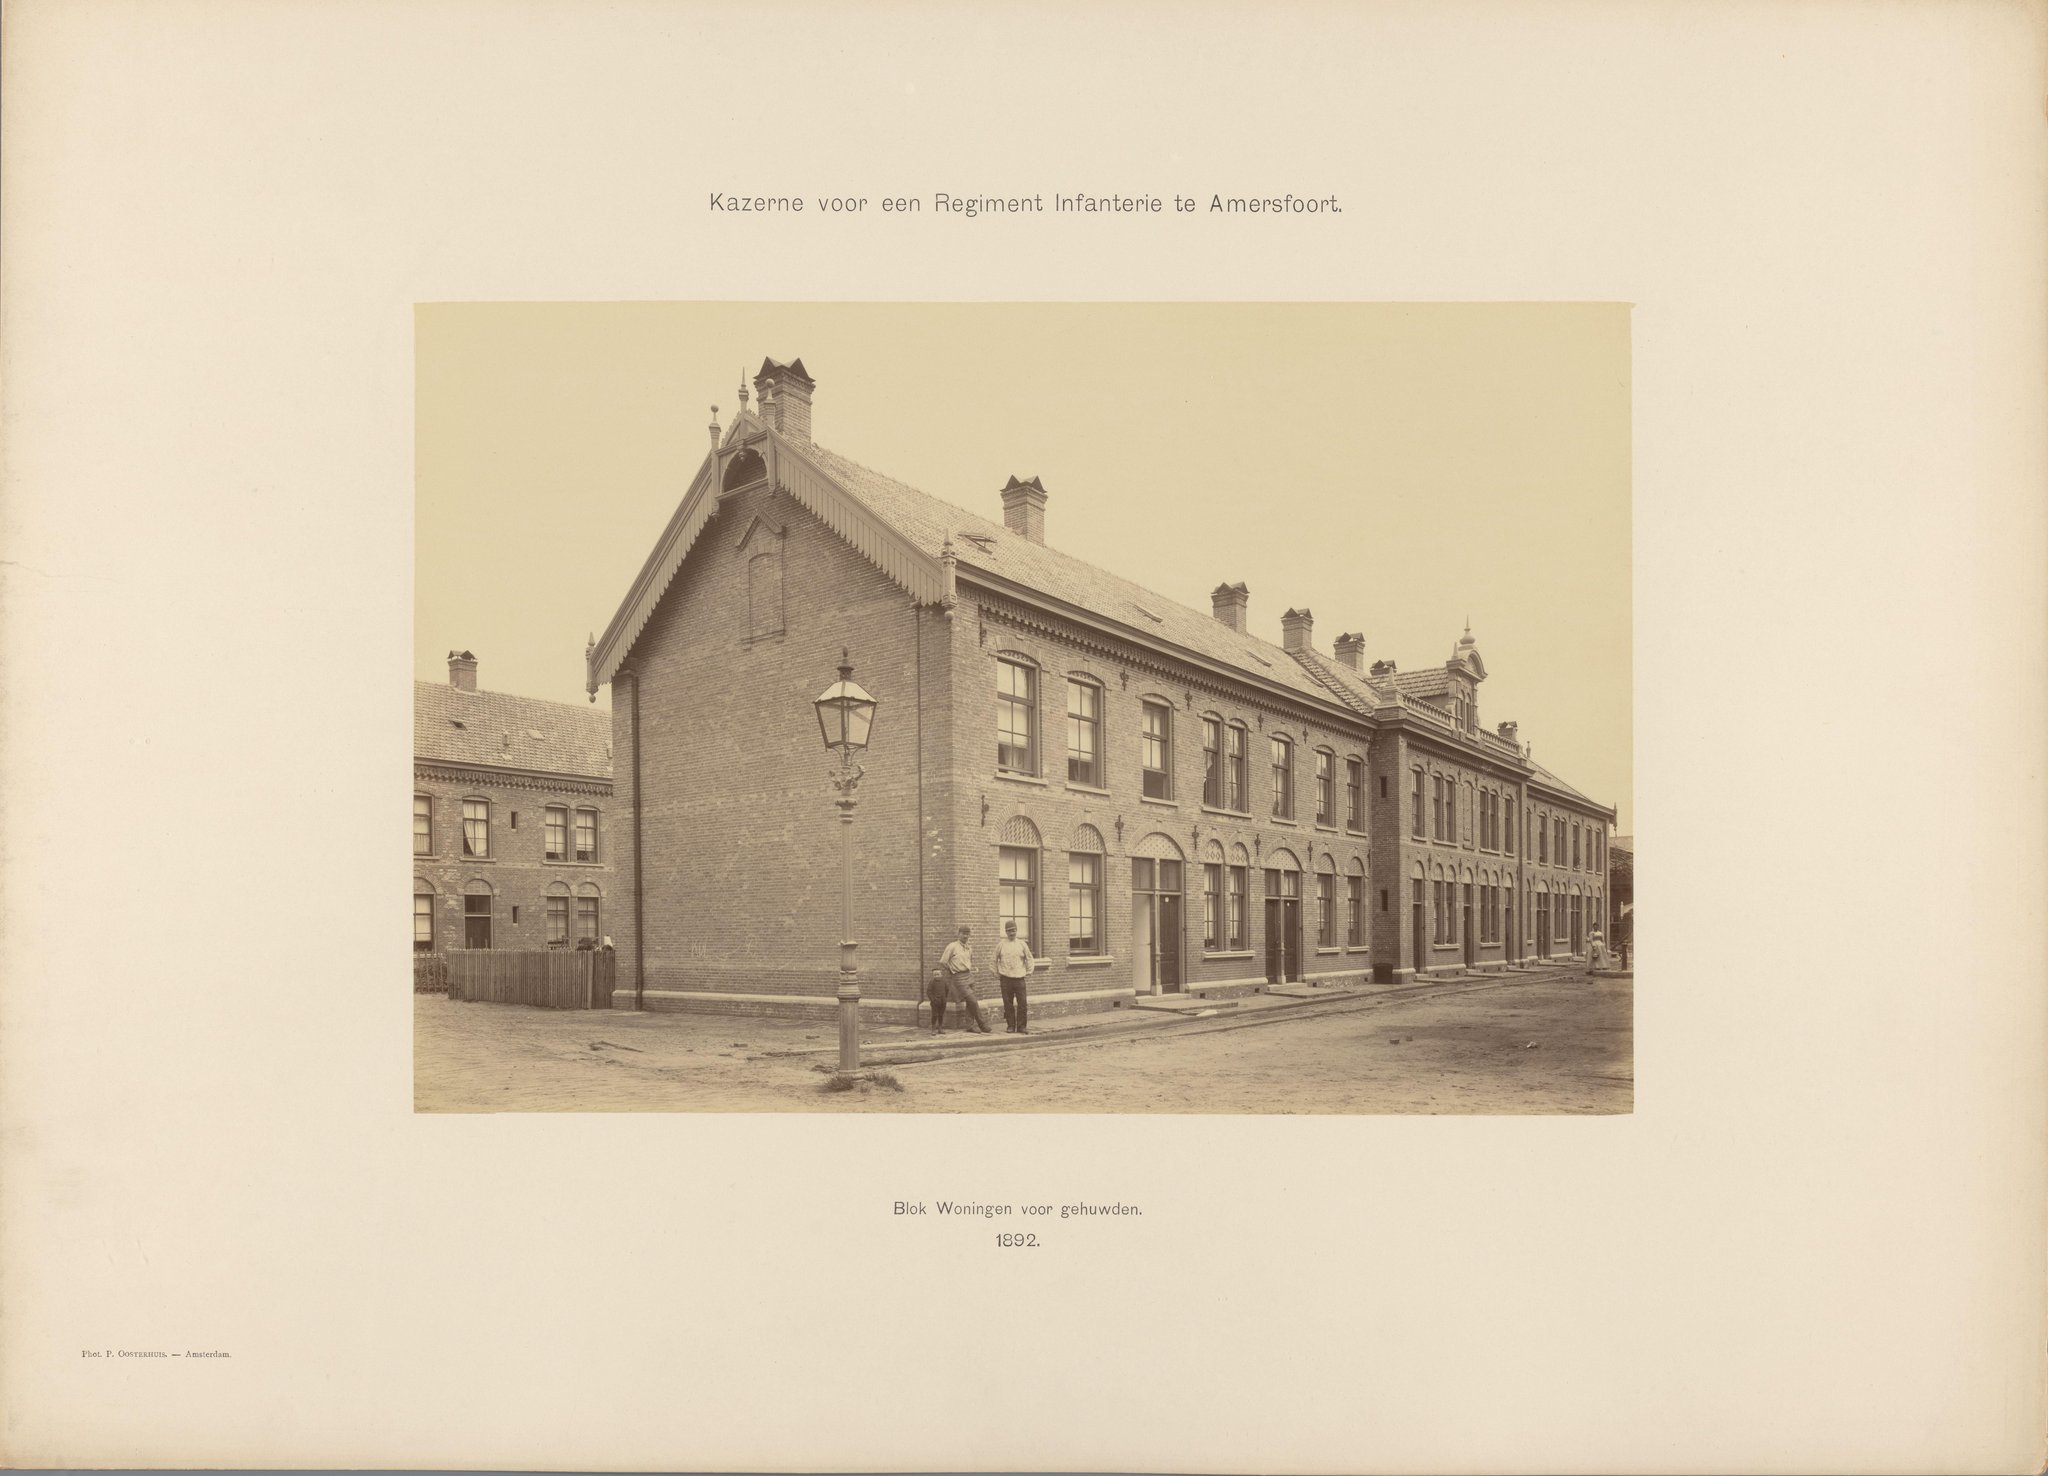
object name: photograph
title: Kazerne voor een Regiment Infanterie te Amersfoort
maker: p. oosterhuis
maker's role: fotograaf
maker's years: 1816-1885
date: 1892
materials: cardboard, paper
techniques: photography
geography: amersfoort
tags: netherlands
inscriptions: date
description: Foto, geelbruin, op karton, met boven titel en onder omschrijving. Opschrift; m.o.: 'Blok woningen voor gehuwden'.